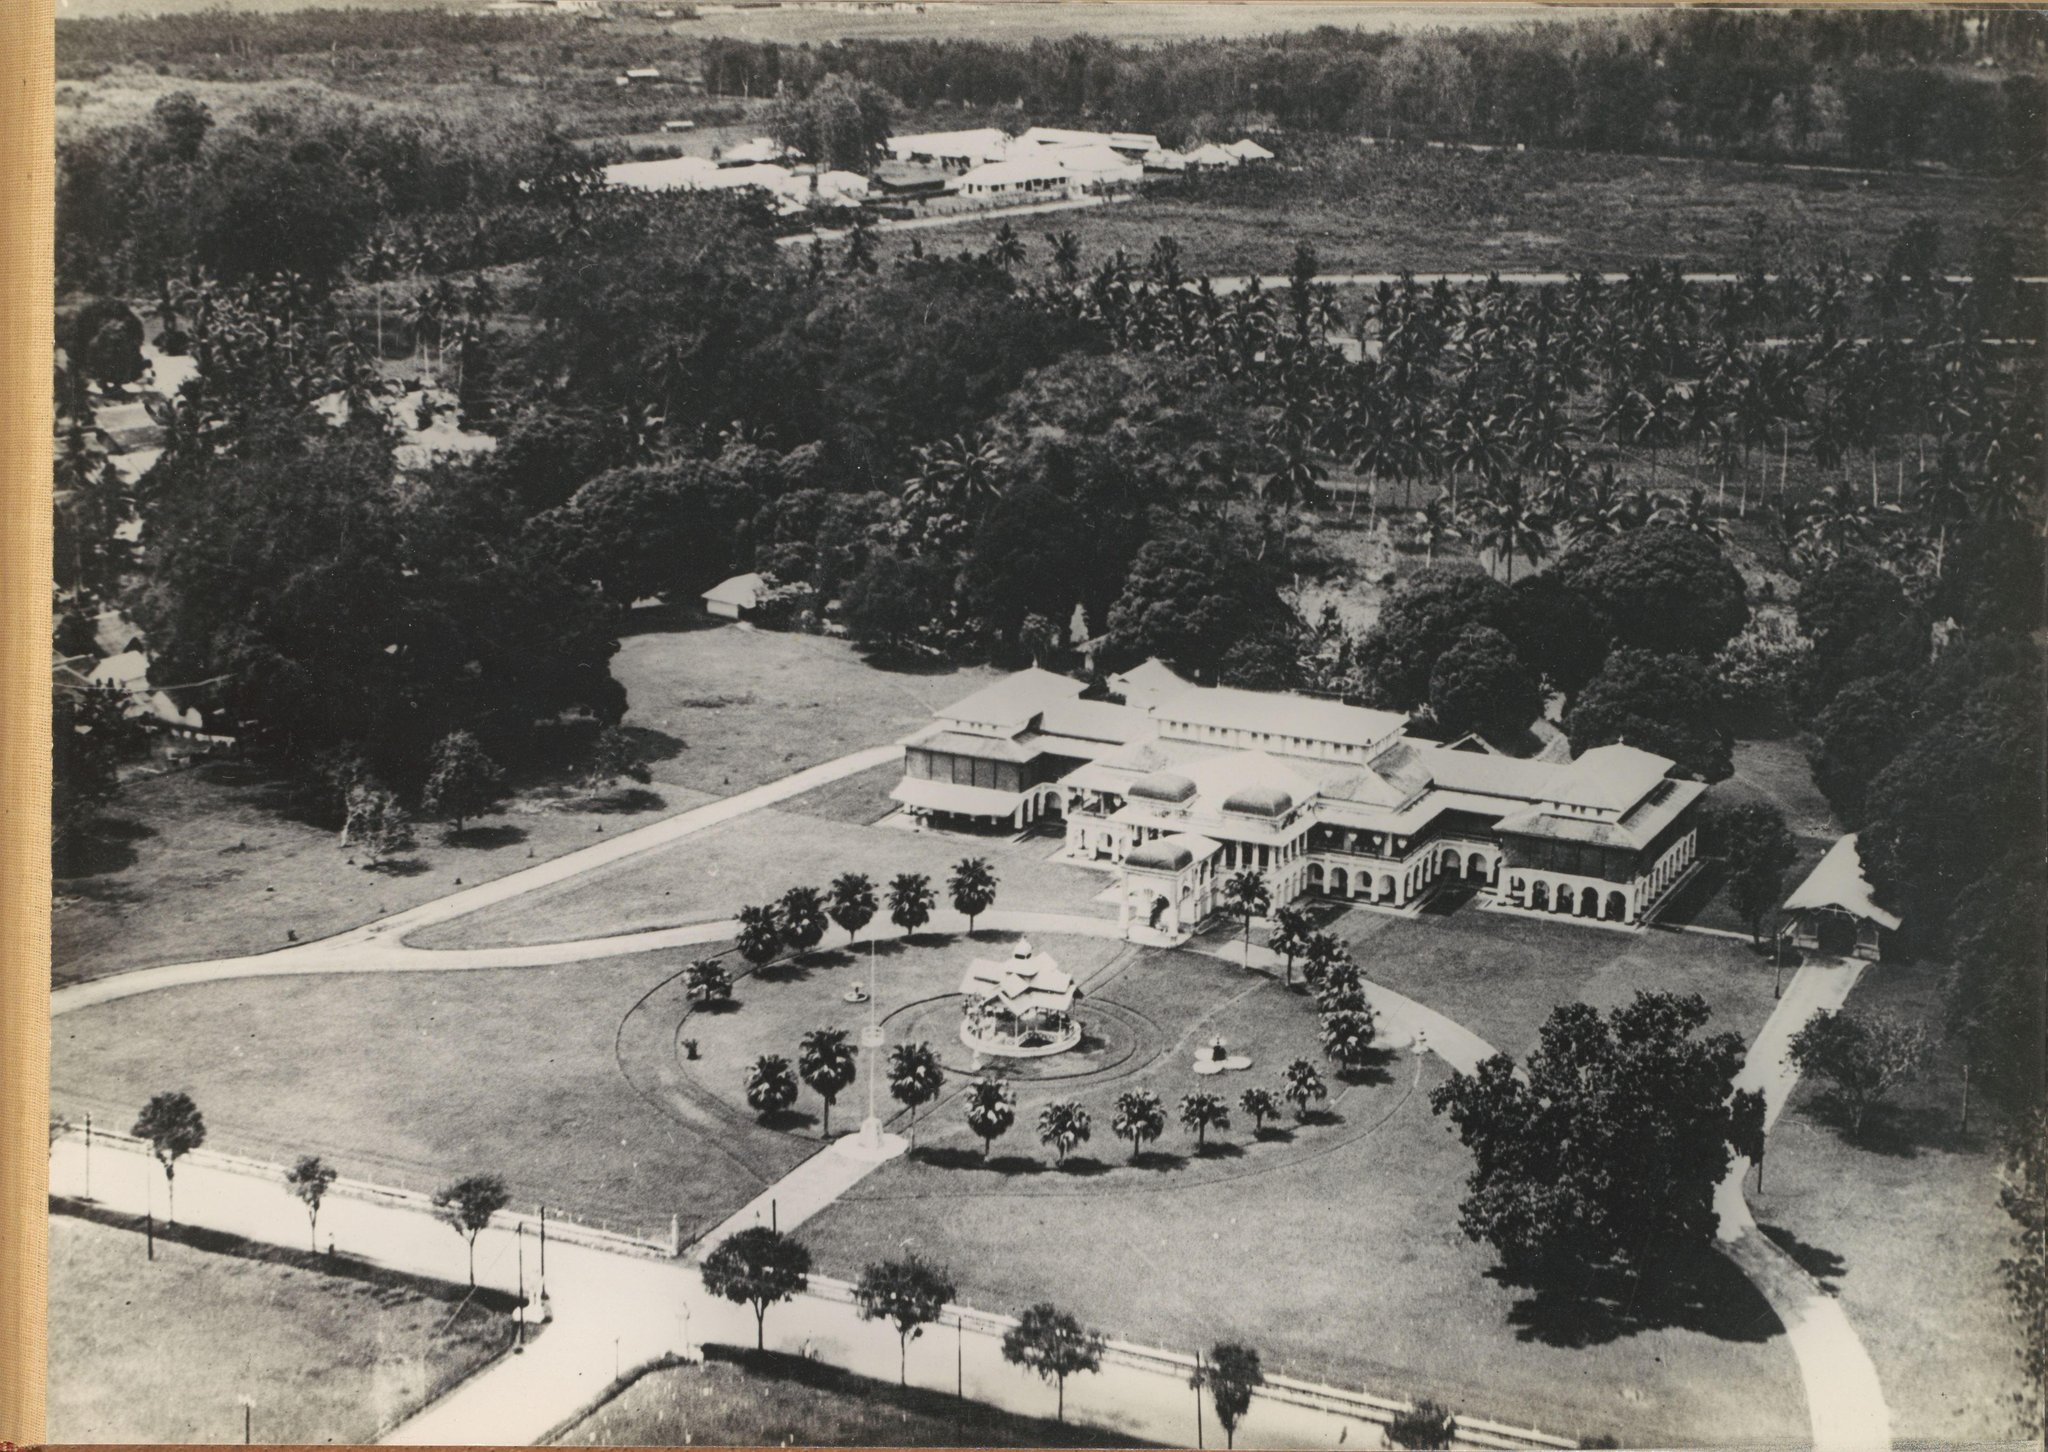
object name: photograph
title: Paleis in Medan, gezien vanuit de lucht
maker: Anonymous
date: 1930-1940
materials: cardboard, paper, photographic support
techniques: gelatin silver print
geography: medan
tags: airborne traffic, aviation, palace, travelling; tourism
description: Albumblad met een foto van het paleis van de sultan van Deli te Medan. De opname is gemaakt op de vliegroute van de KLM-vlucht Amsterdam-Batavia. Onderdeel van Herdenkingsalbum van de Indië-lijn van de KLM, deel I.